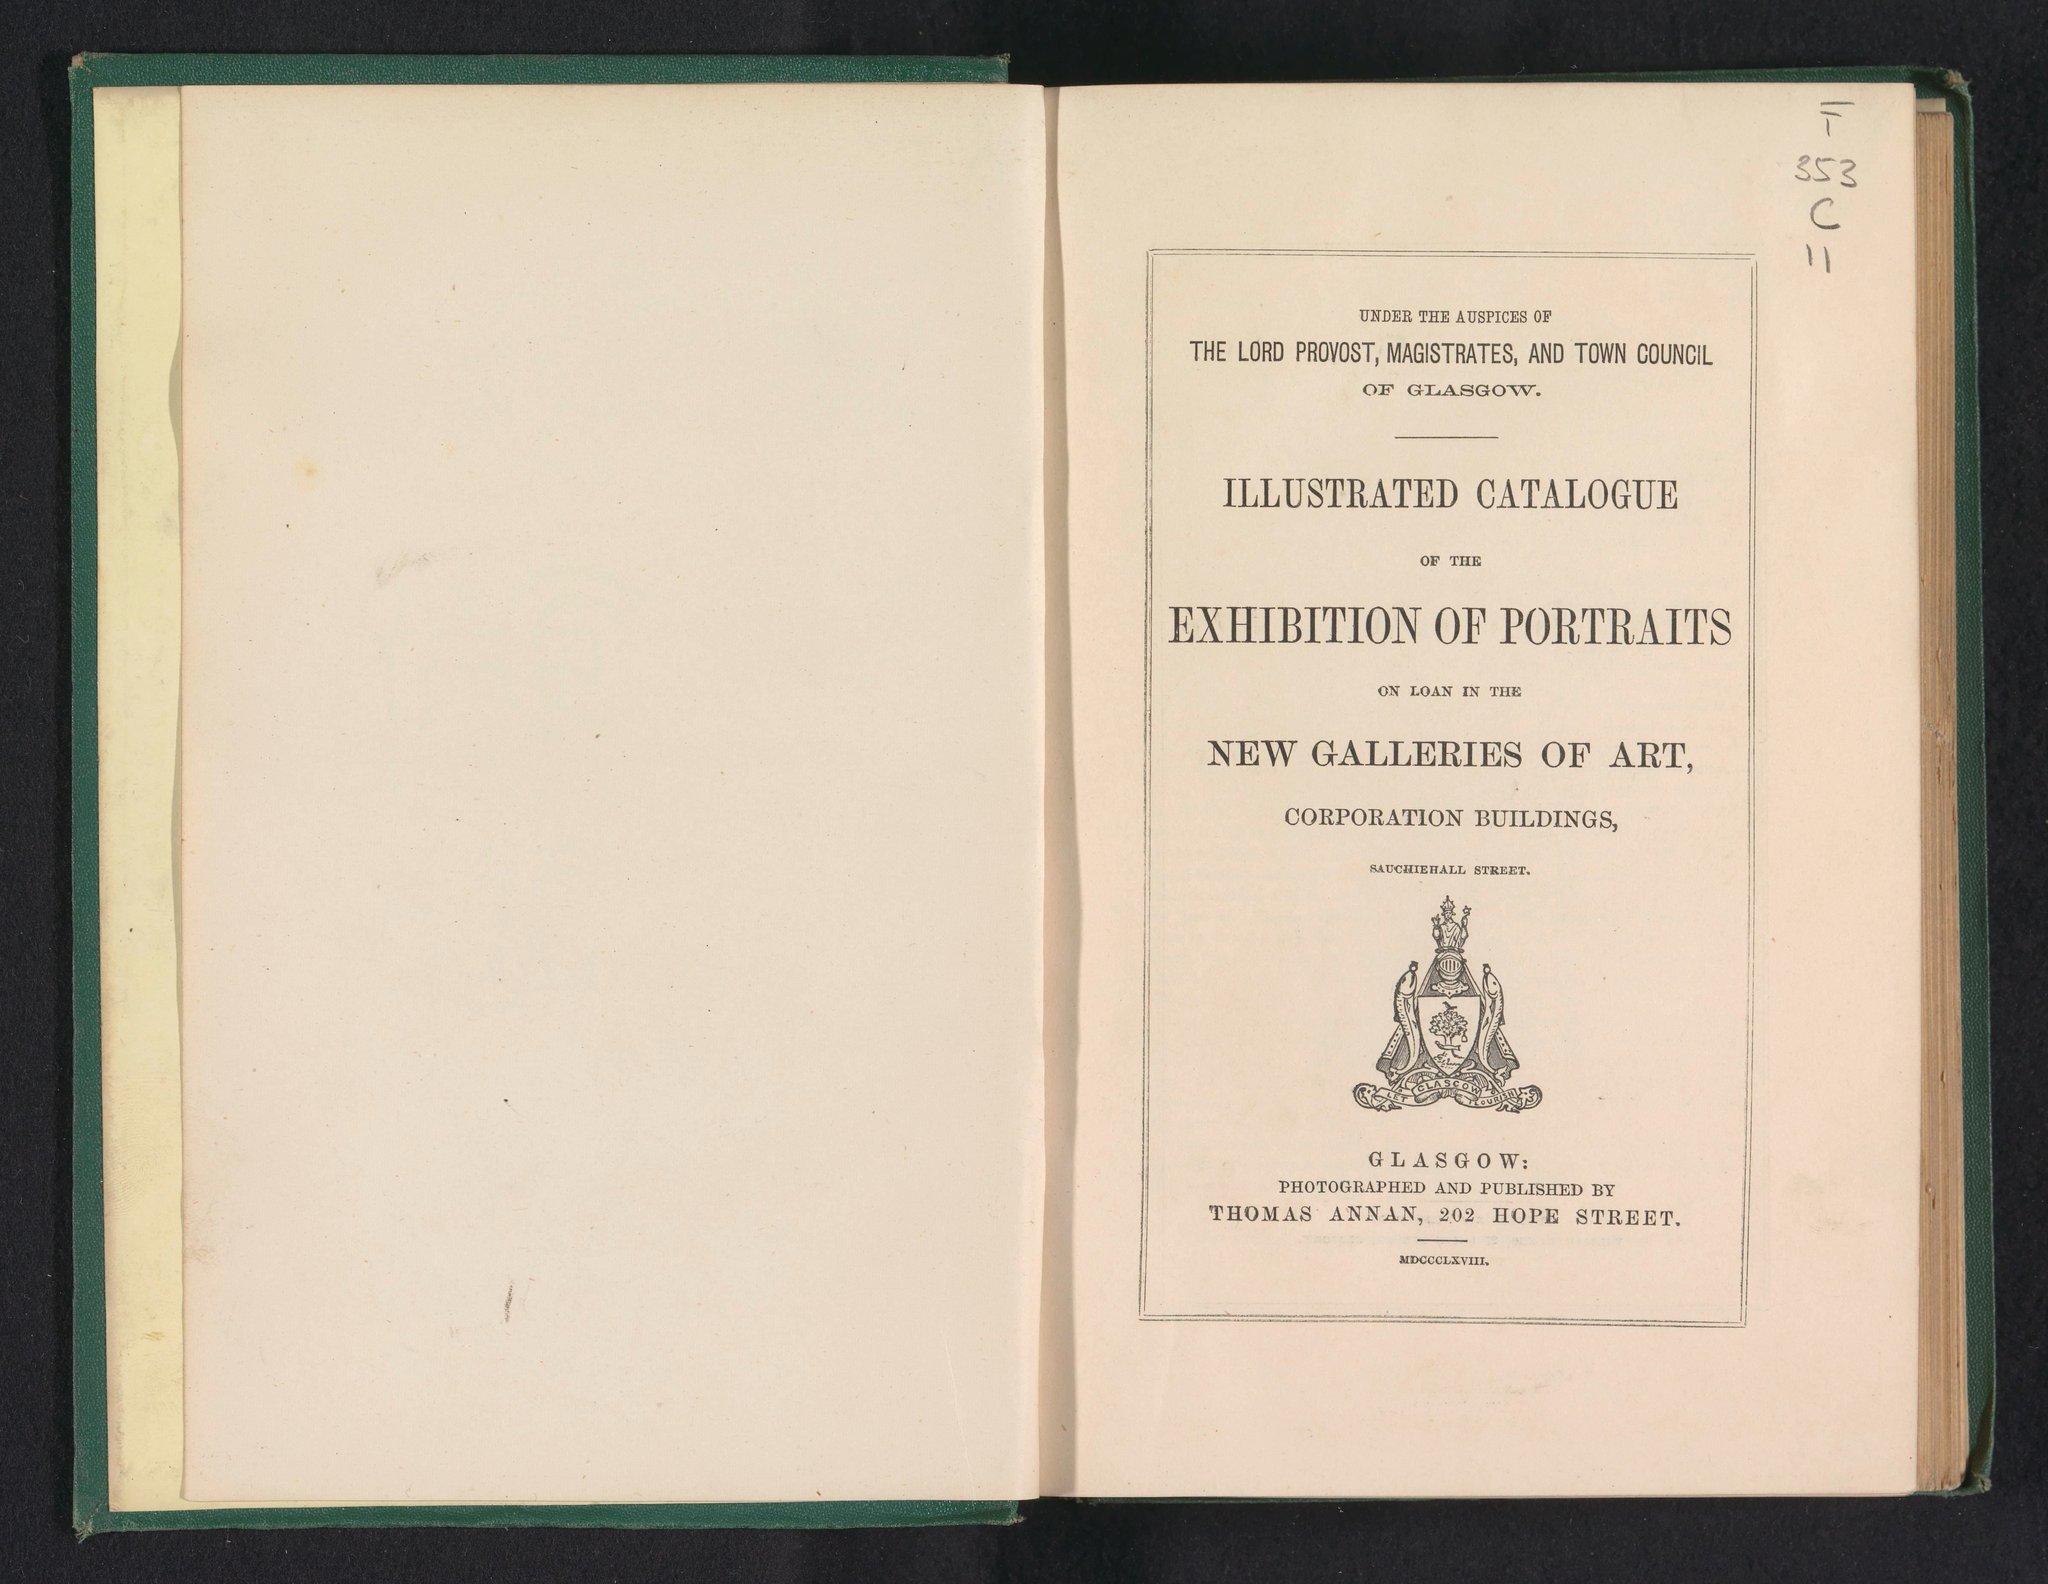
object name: book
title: Illustrated catalogue of the exhibition of portraits on loan in the new Galleries of art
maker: thomas annan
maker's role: fotograaf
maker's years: 1829-1887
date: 1868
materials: cardboard, linen, paper, photographic support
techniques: albumen print, printing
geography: glasgow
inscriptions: inscription: ‘ex libris SFJ’